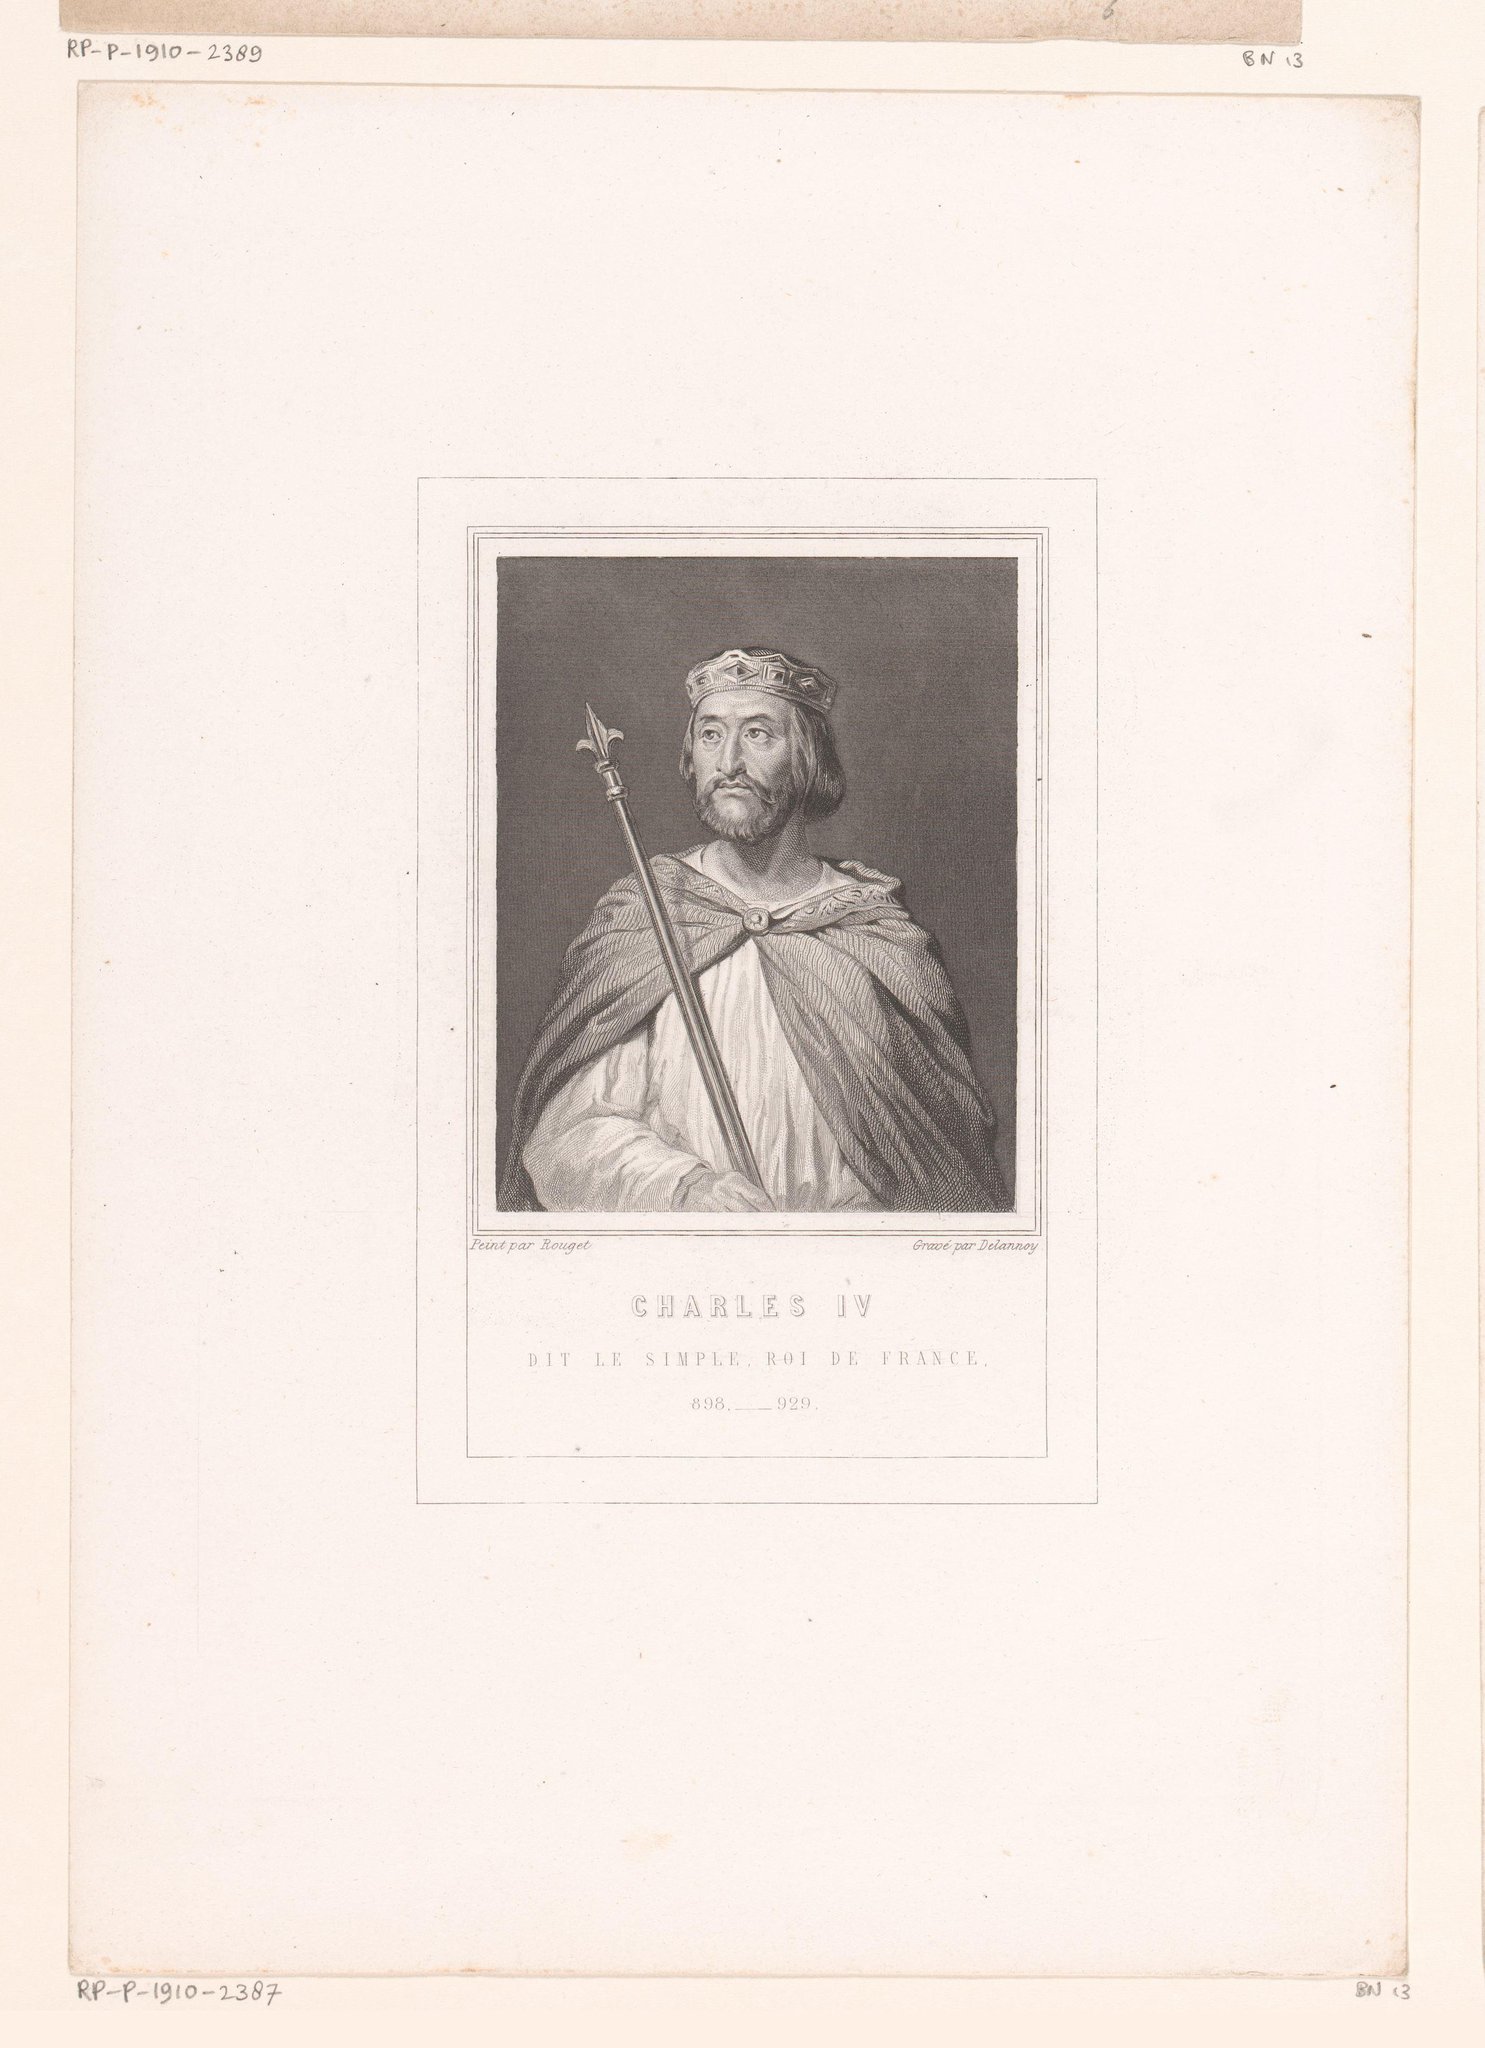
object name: book illustration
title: Hugues Capet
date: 1838-1841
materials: paper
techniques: engraving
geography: france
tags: historical persons, king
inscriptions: collector's mark: Lugt 2228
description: Prent uit: s.n. Galeries historiques de Versailles. Parijs: Charles Gavard, 1838-1841.